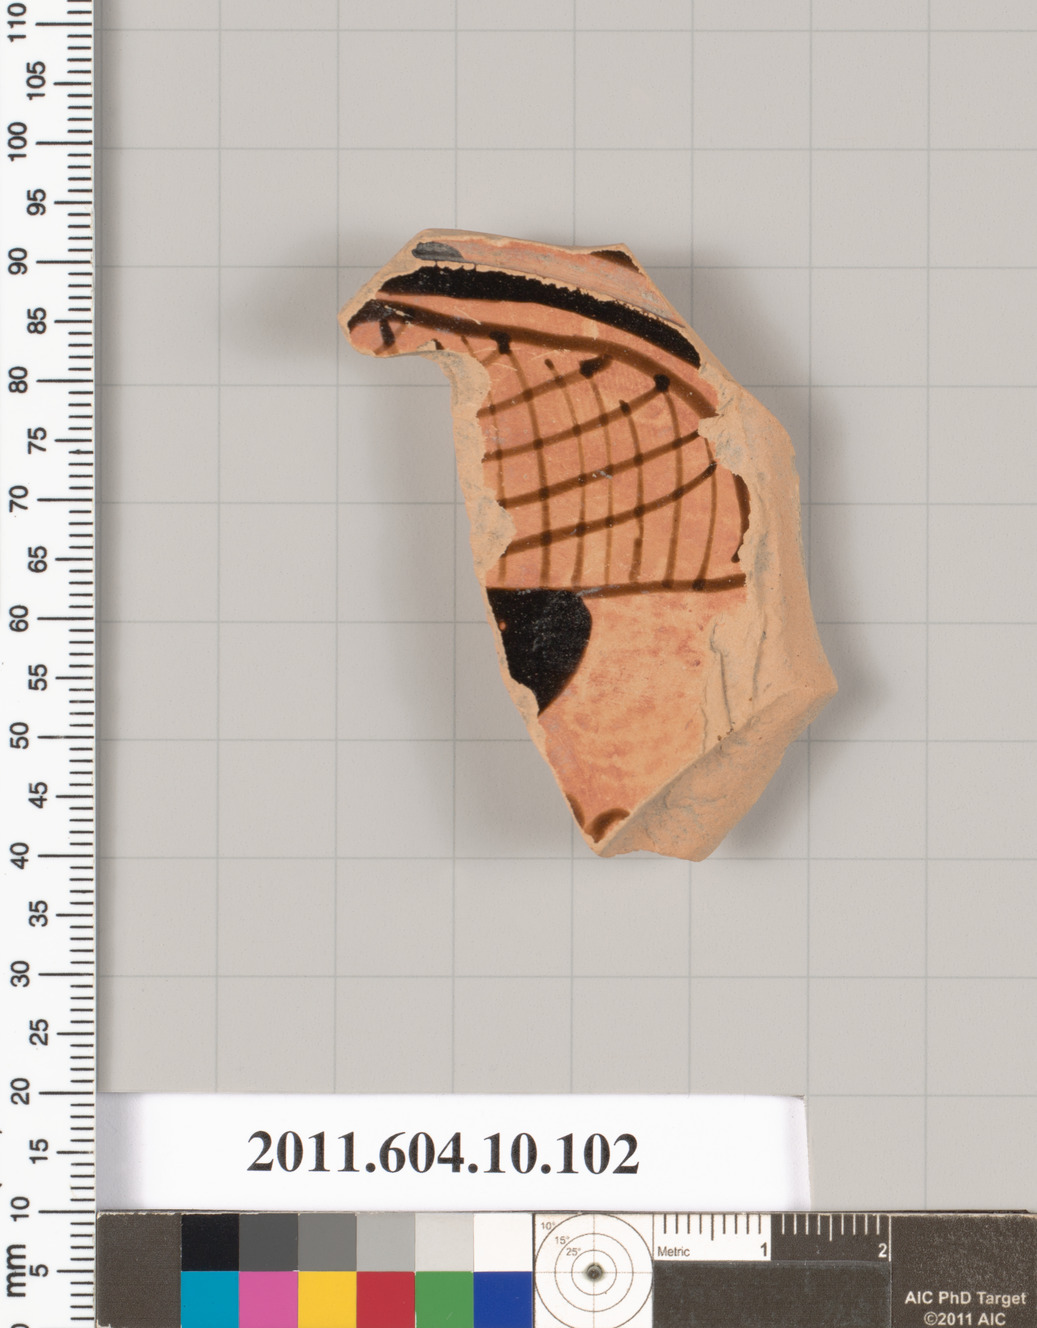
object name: genucilia plate fragment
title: Terracotta fragment of a Genucilia plate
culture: etruscan, genucilia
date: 367-335 BCE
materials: terracotta